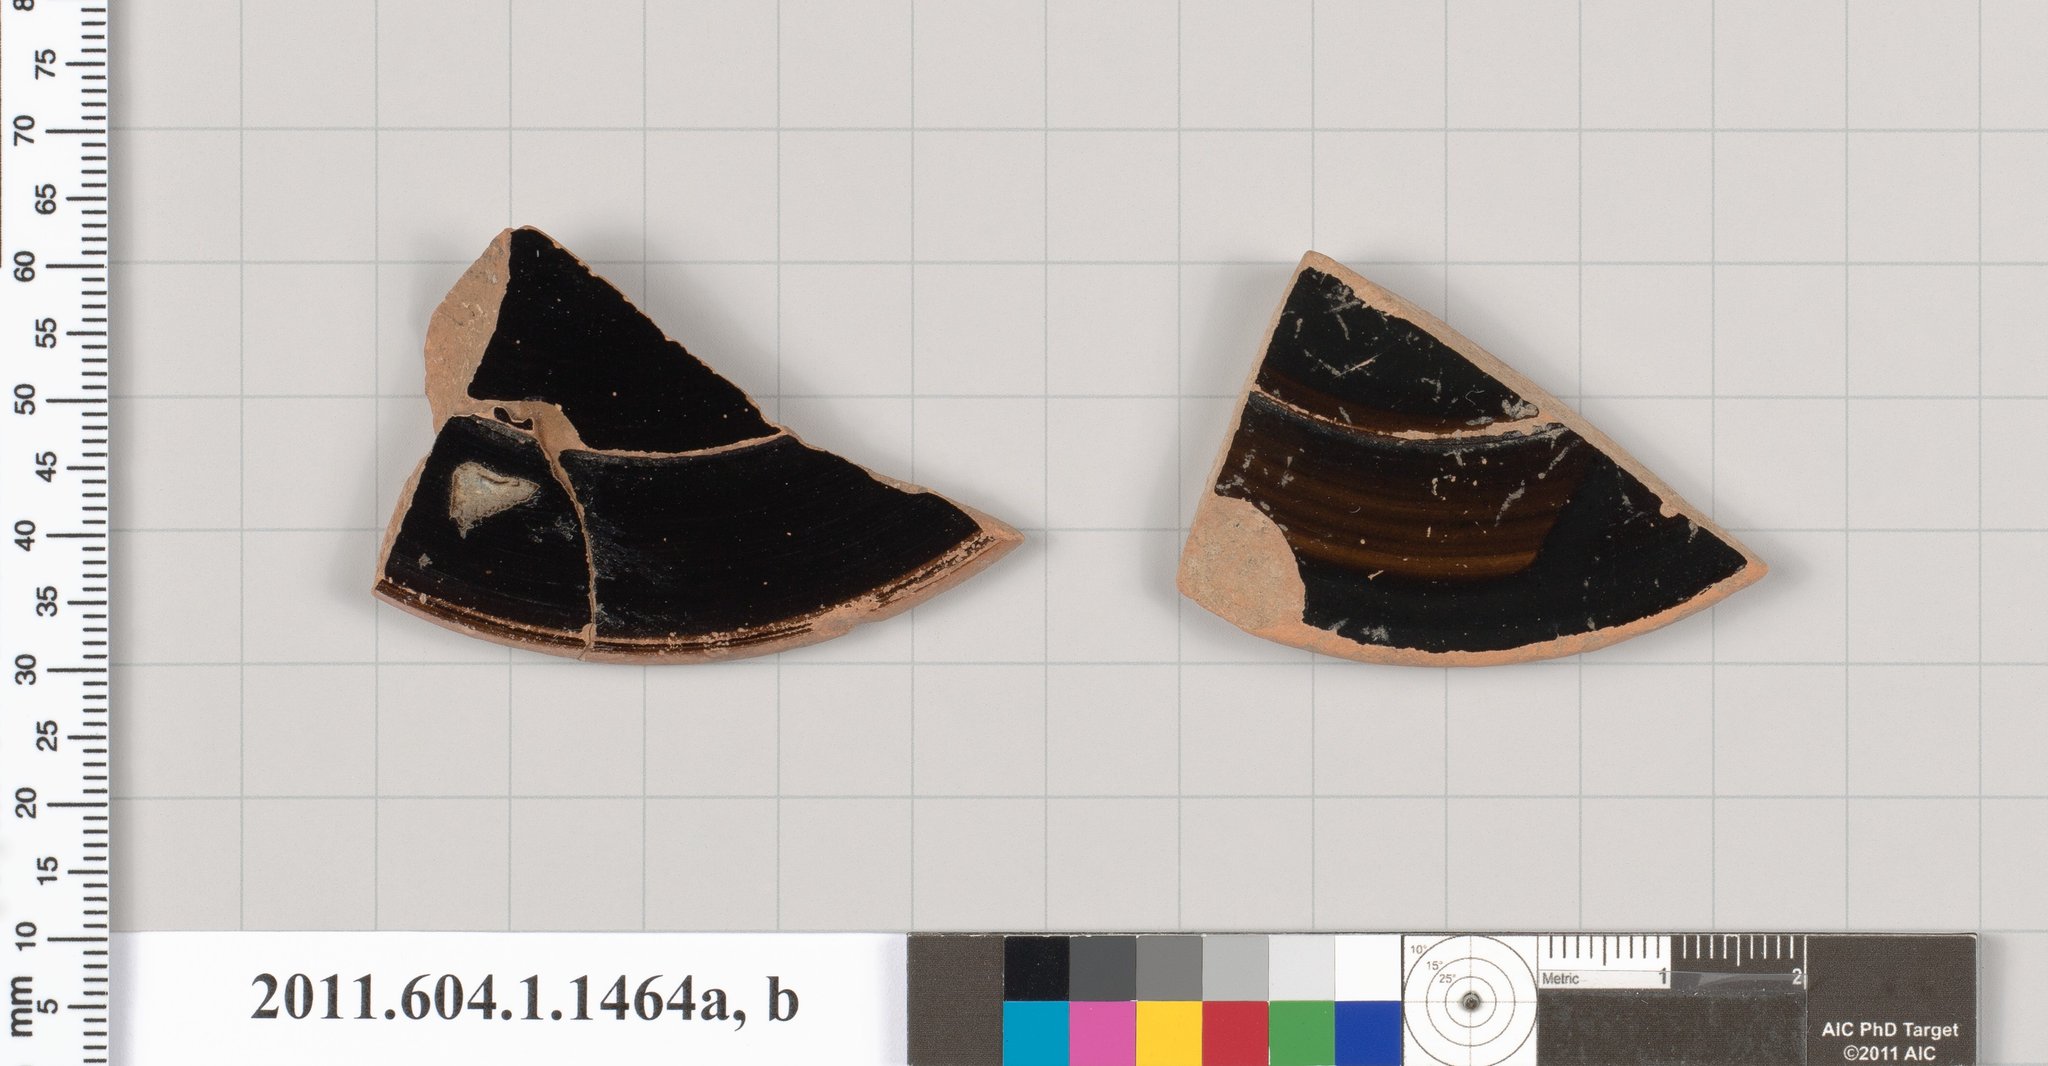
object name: kylix fragment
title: Terracotta fragments of kylikes (drinking cups)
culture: greek, attic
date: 500-401 BCE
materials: terracotta